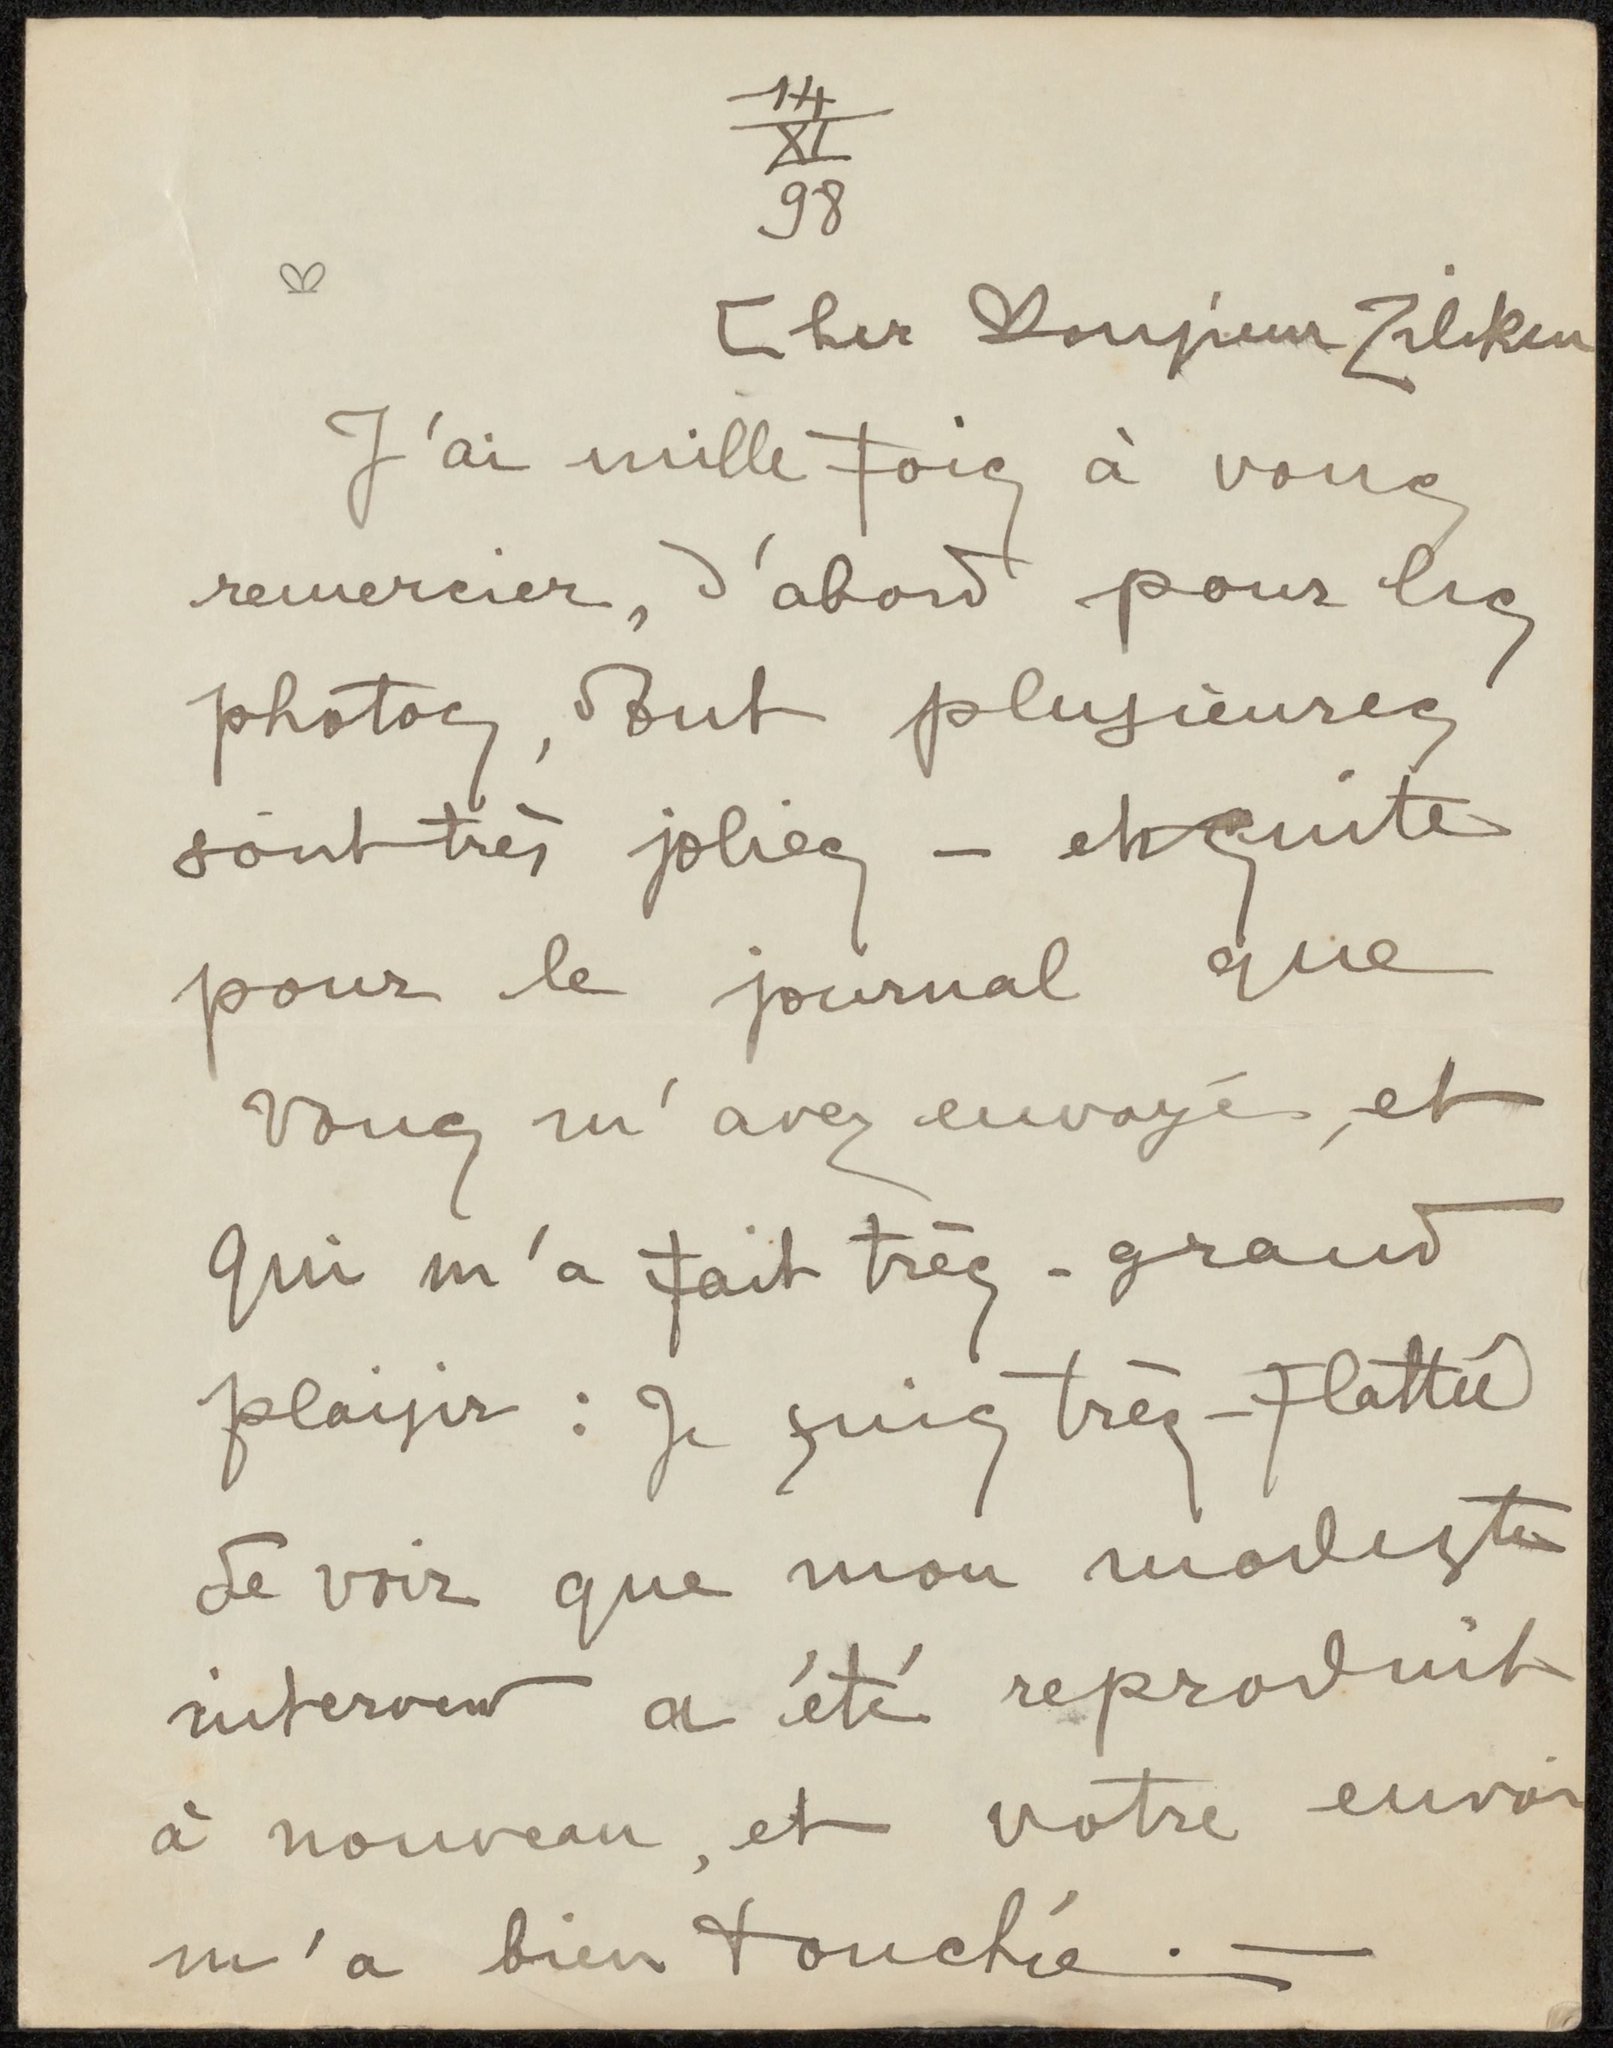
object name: letter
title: Brief aan Philip Zilcken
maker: baronne madeleine deslandes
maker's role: schrijver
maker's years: 1866-1929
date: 1898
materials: ink, paper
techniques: pen, writing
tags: the hague, painter, philip zilcken, photography, cinematography, family life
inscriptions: collector's mark: ‘RPK’